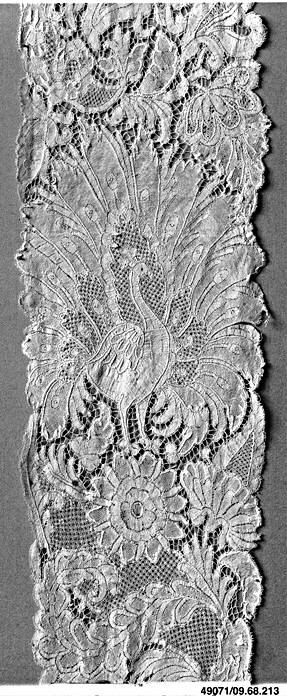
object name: lappet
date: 1701-1733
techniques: lace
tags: peacocks,flowers